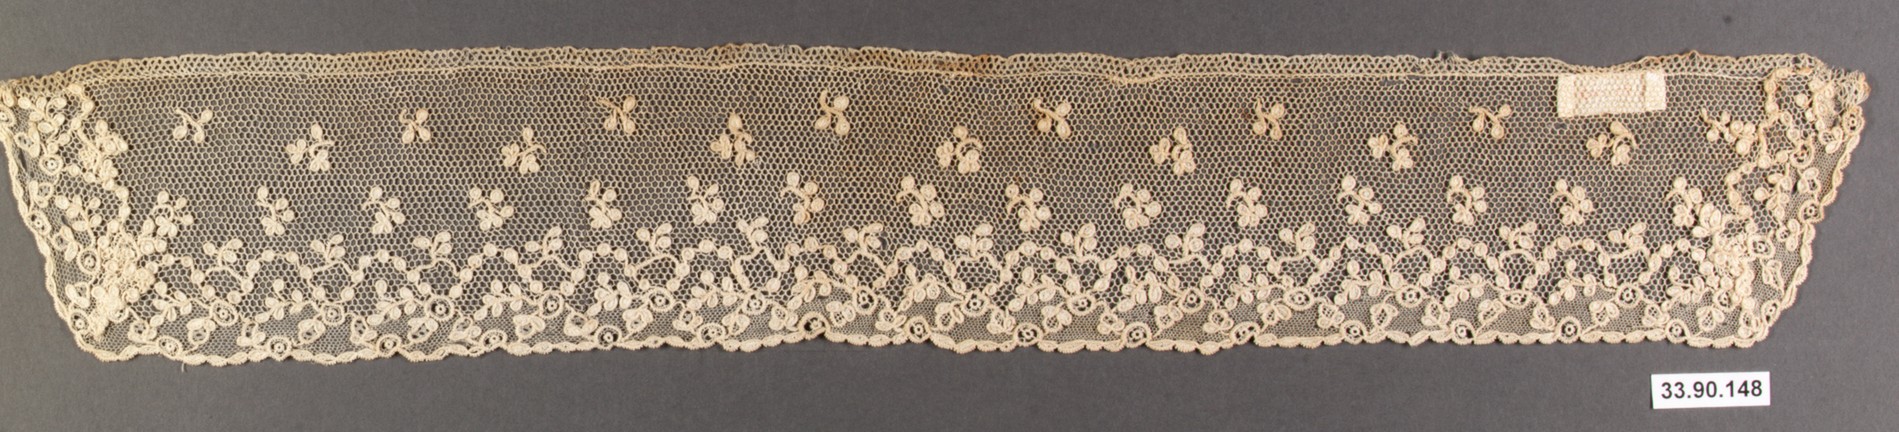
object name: edging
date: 1767-1800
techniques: lace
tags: flowers